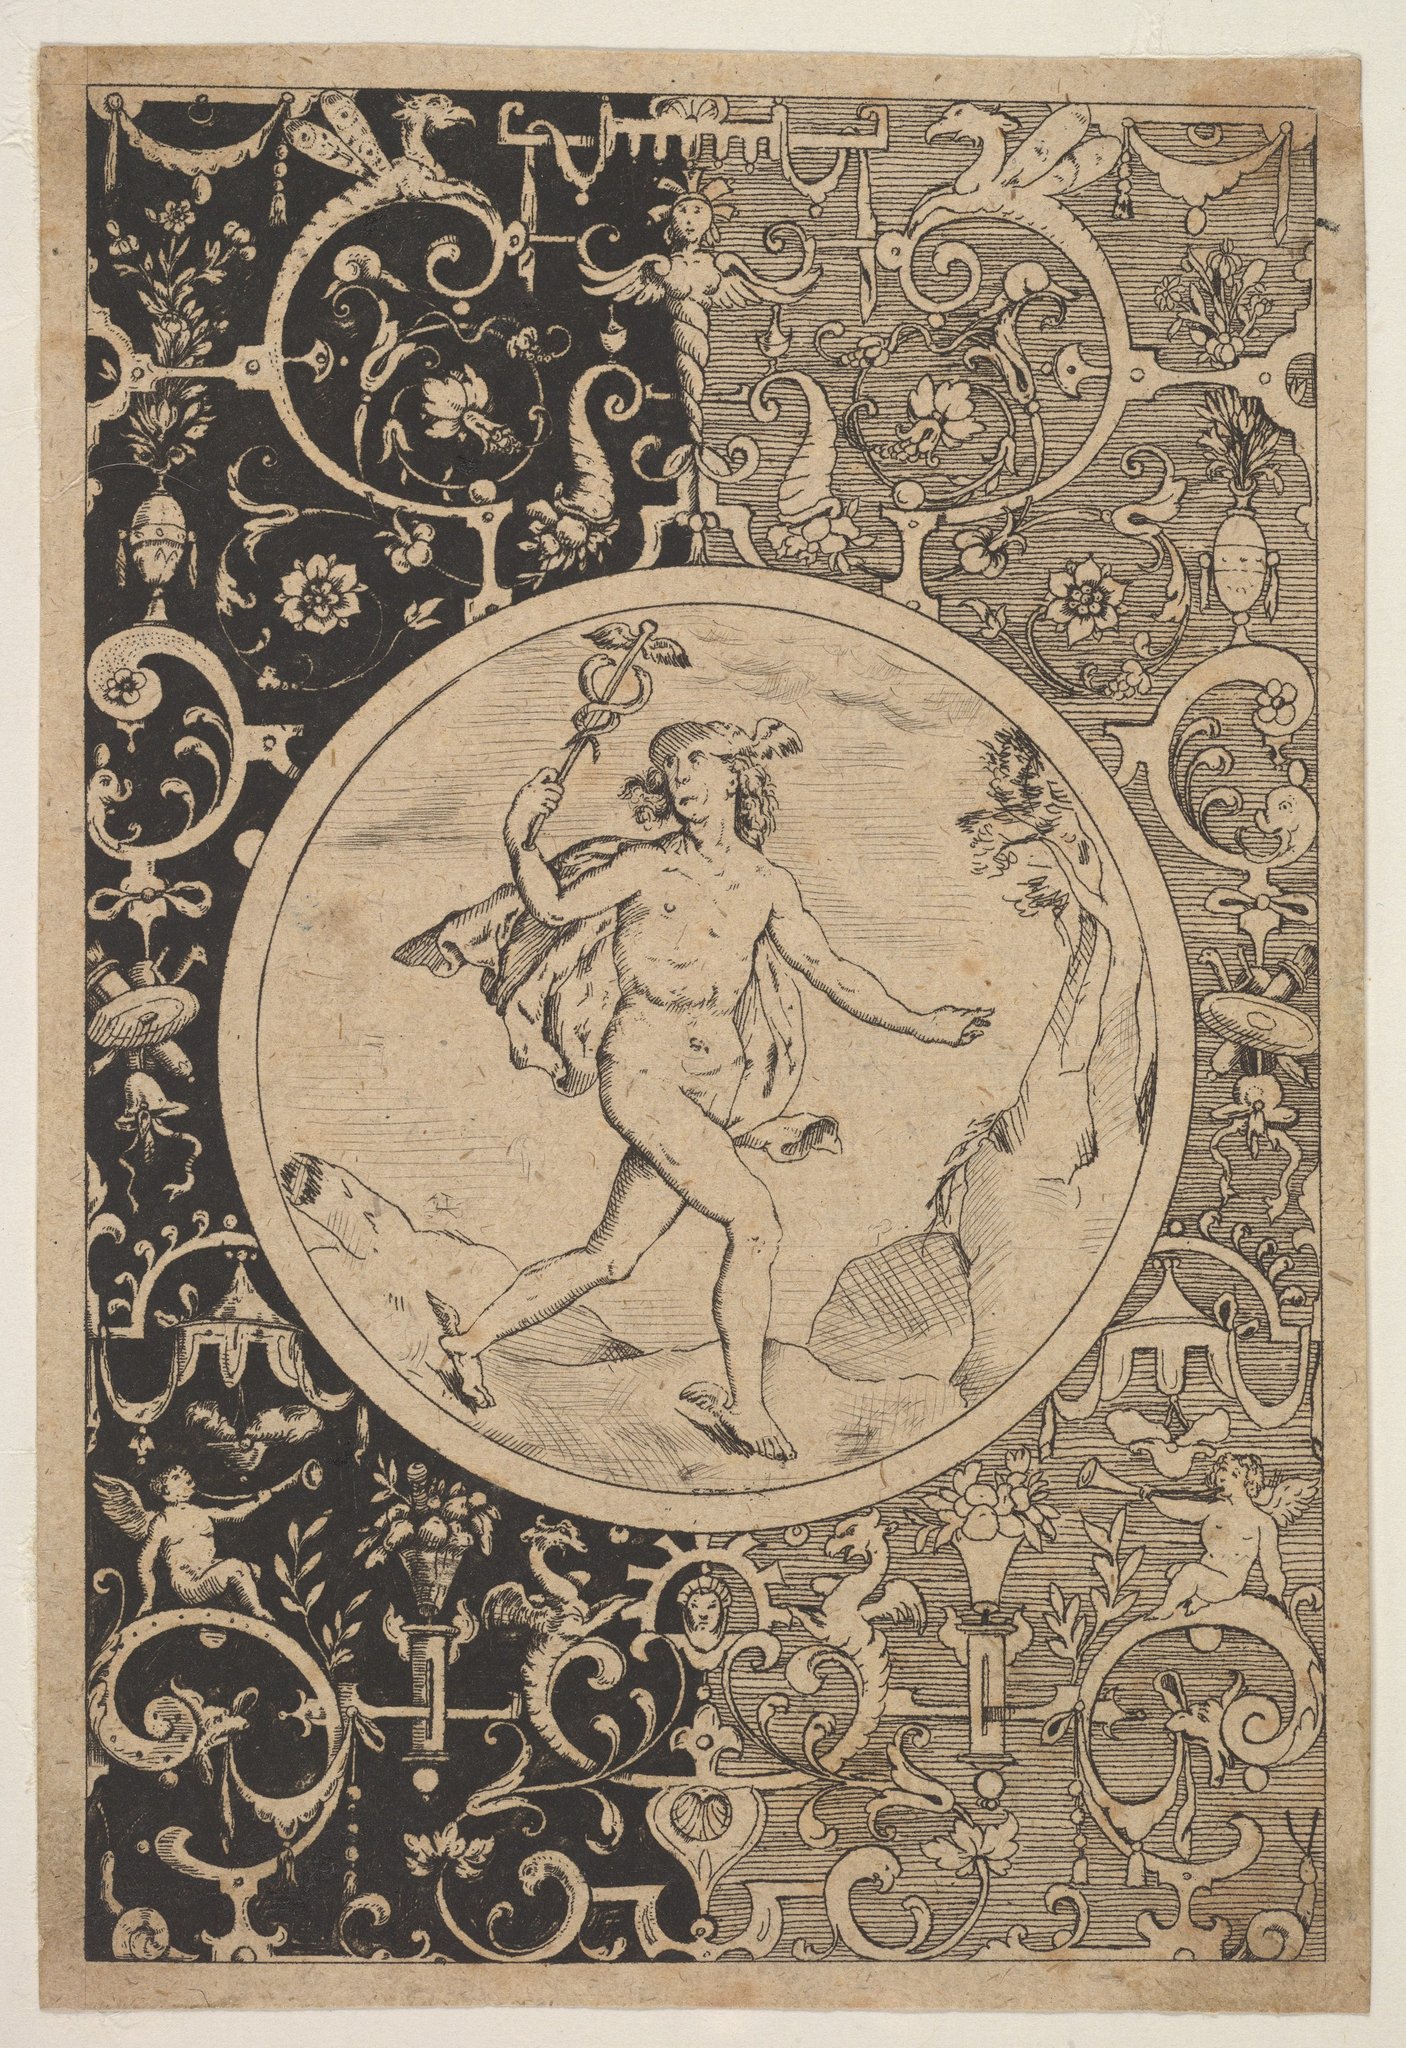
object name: print collection ornament architecture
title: Mercury in a Decorative Frame with Grotesques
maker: adriaen collaert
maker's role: artist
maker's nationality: netherlandish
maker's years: 1560-1618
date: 1600-1630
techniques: embroidery, engraving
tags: grotesques,ornament,mercury